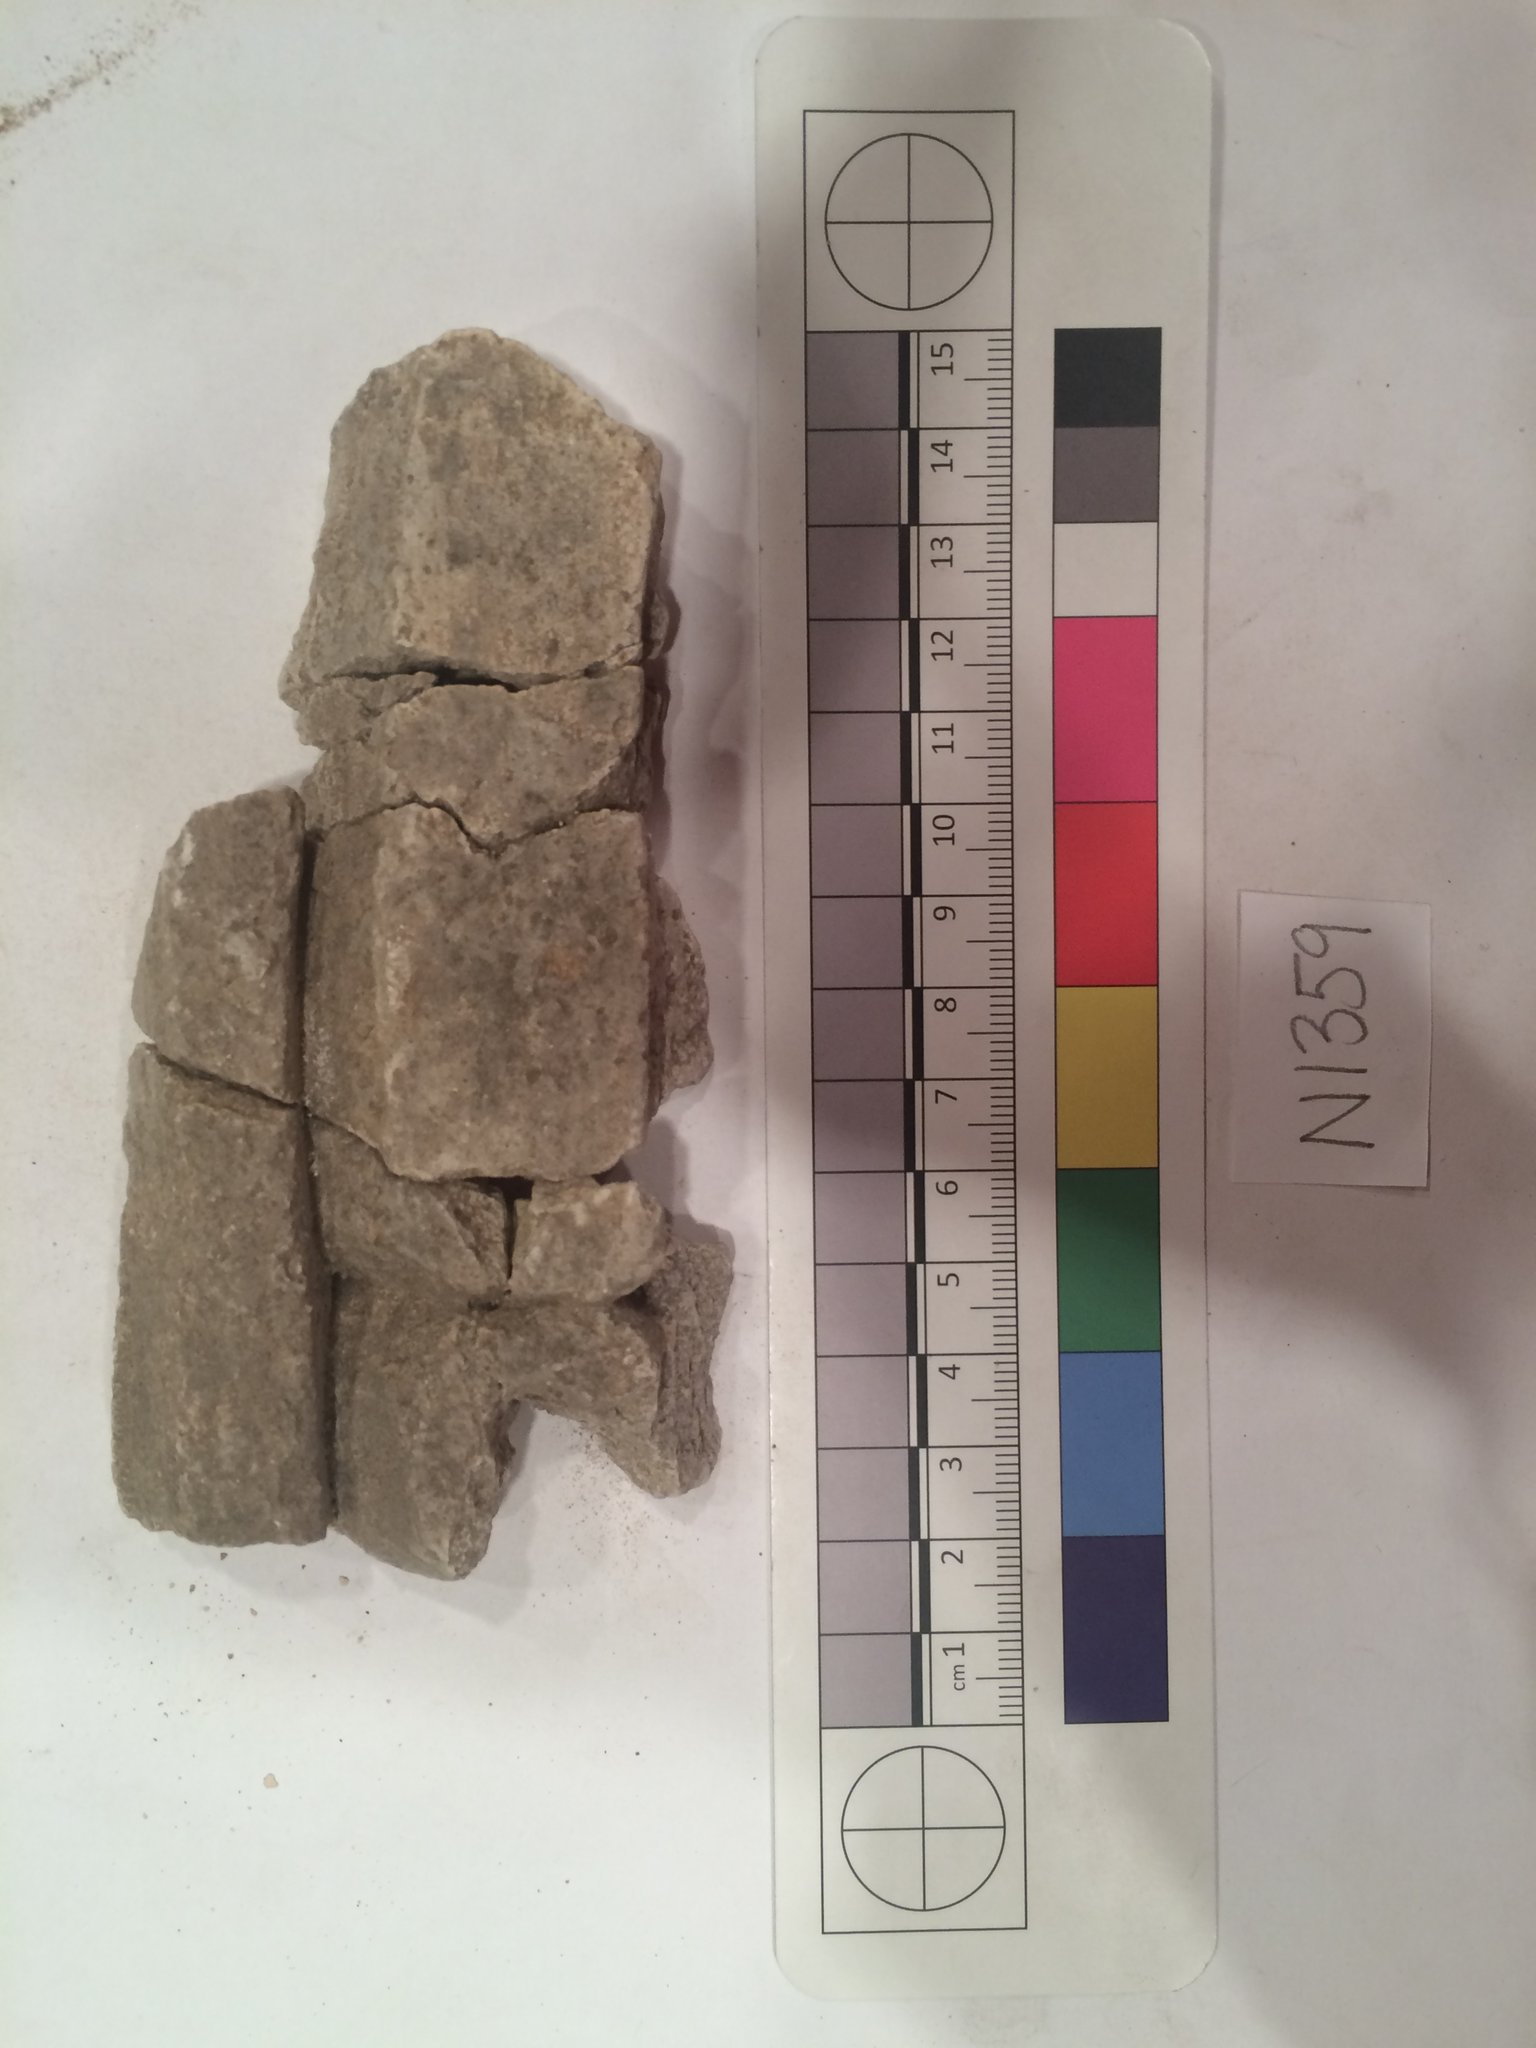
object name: fragment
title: Stucco Fragment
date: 701-1200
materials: plaster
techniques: carving, painting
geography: iran